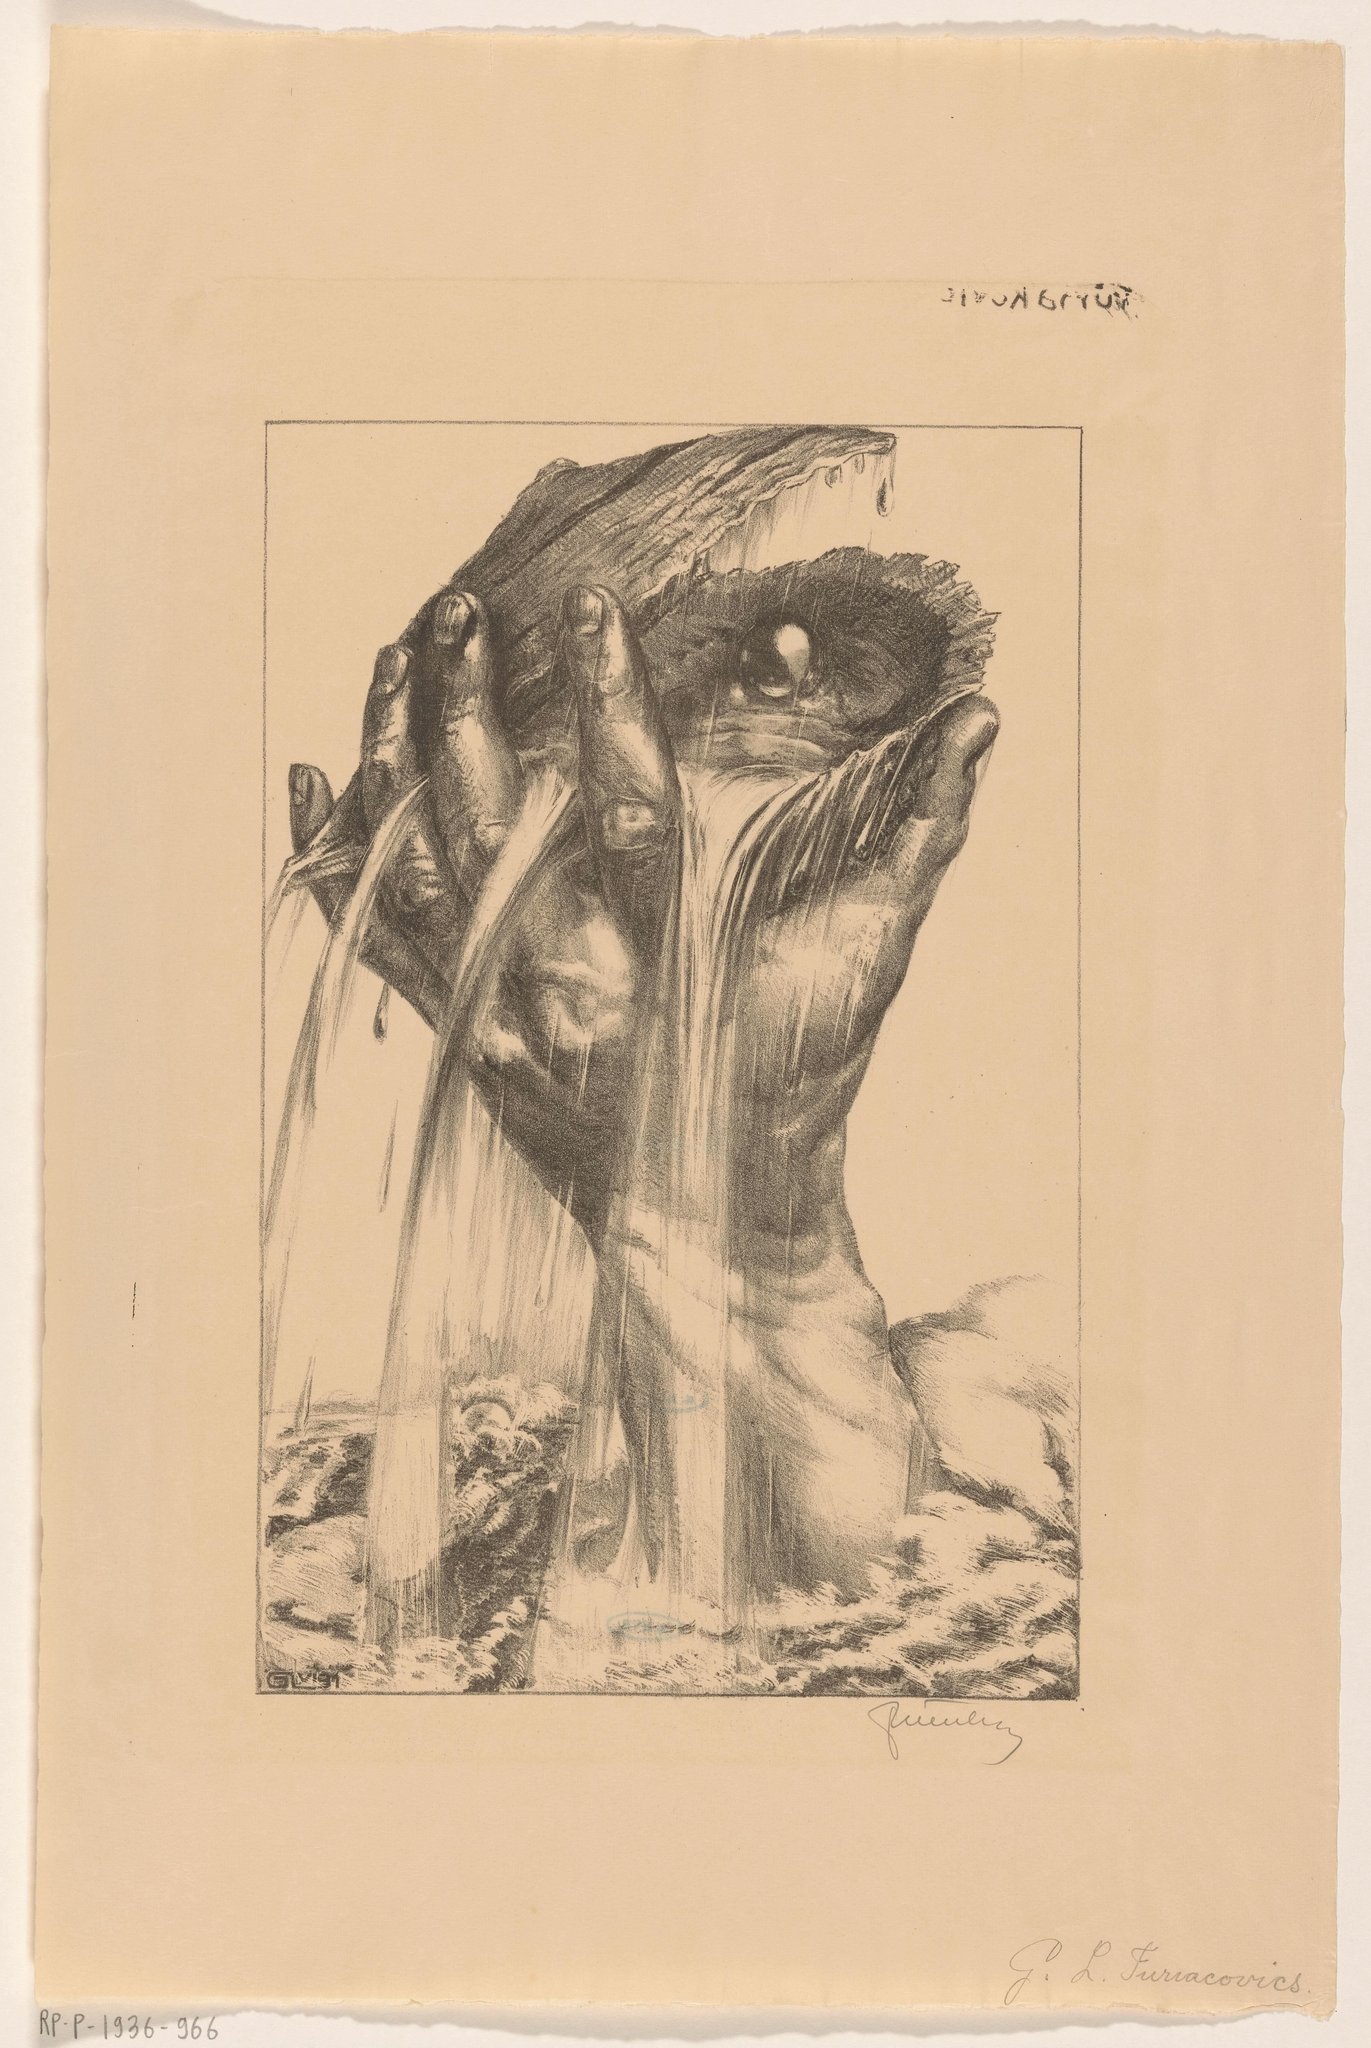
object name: print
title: Hand die een oester met parel uit zee opheft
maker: g.l. furiacovics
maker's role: print maker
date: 1931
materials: paper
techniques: lithograph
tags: pearl fishing, pearl diving; coral fishing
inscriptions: collector's mark: Lugt 2228